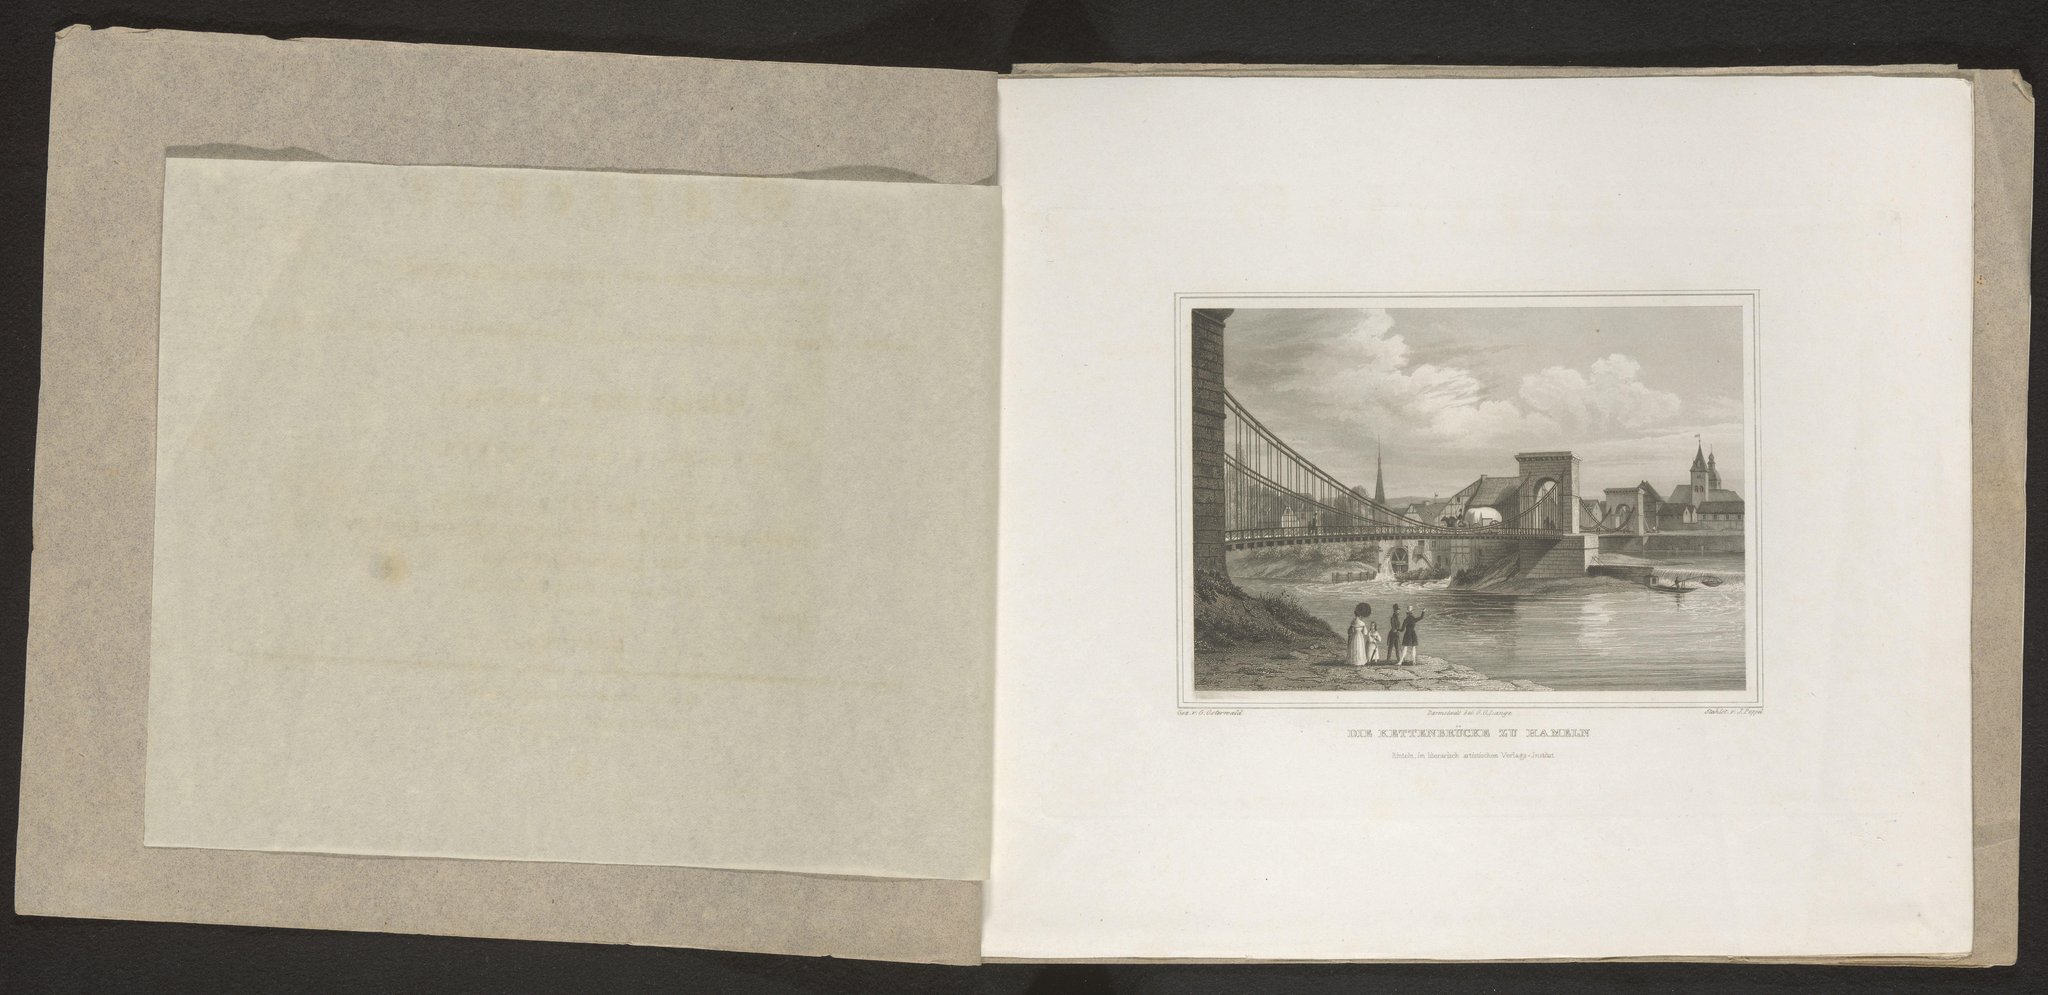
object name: print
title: Die Kettenbrücke zu Hameln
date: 1839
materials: paper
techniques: engraving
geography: rinteln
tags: bridge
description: Deze prent maakt deel uit van een omslag met drie prenten.